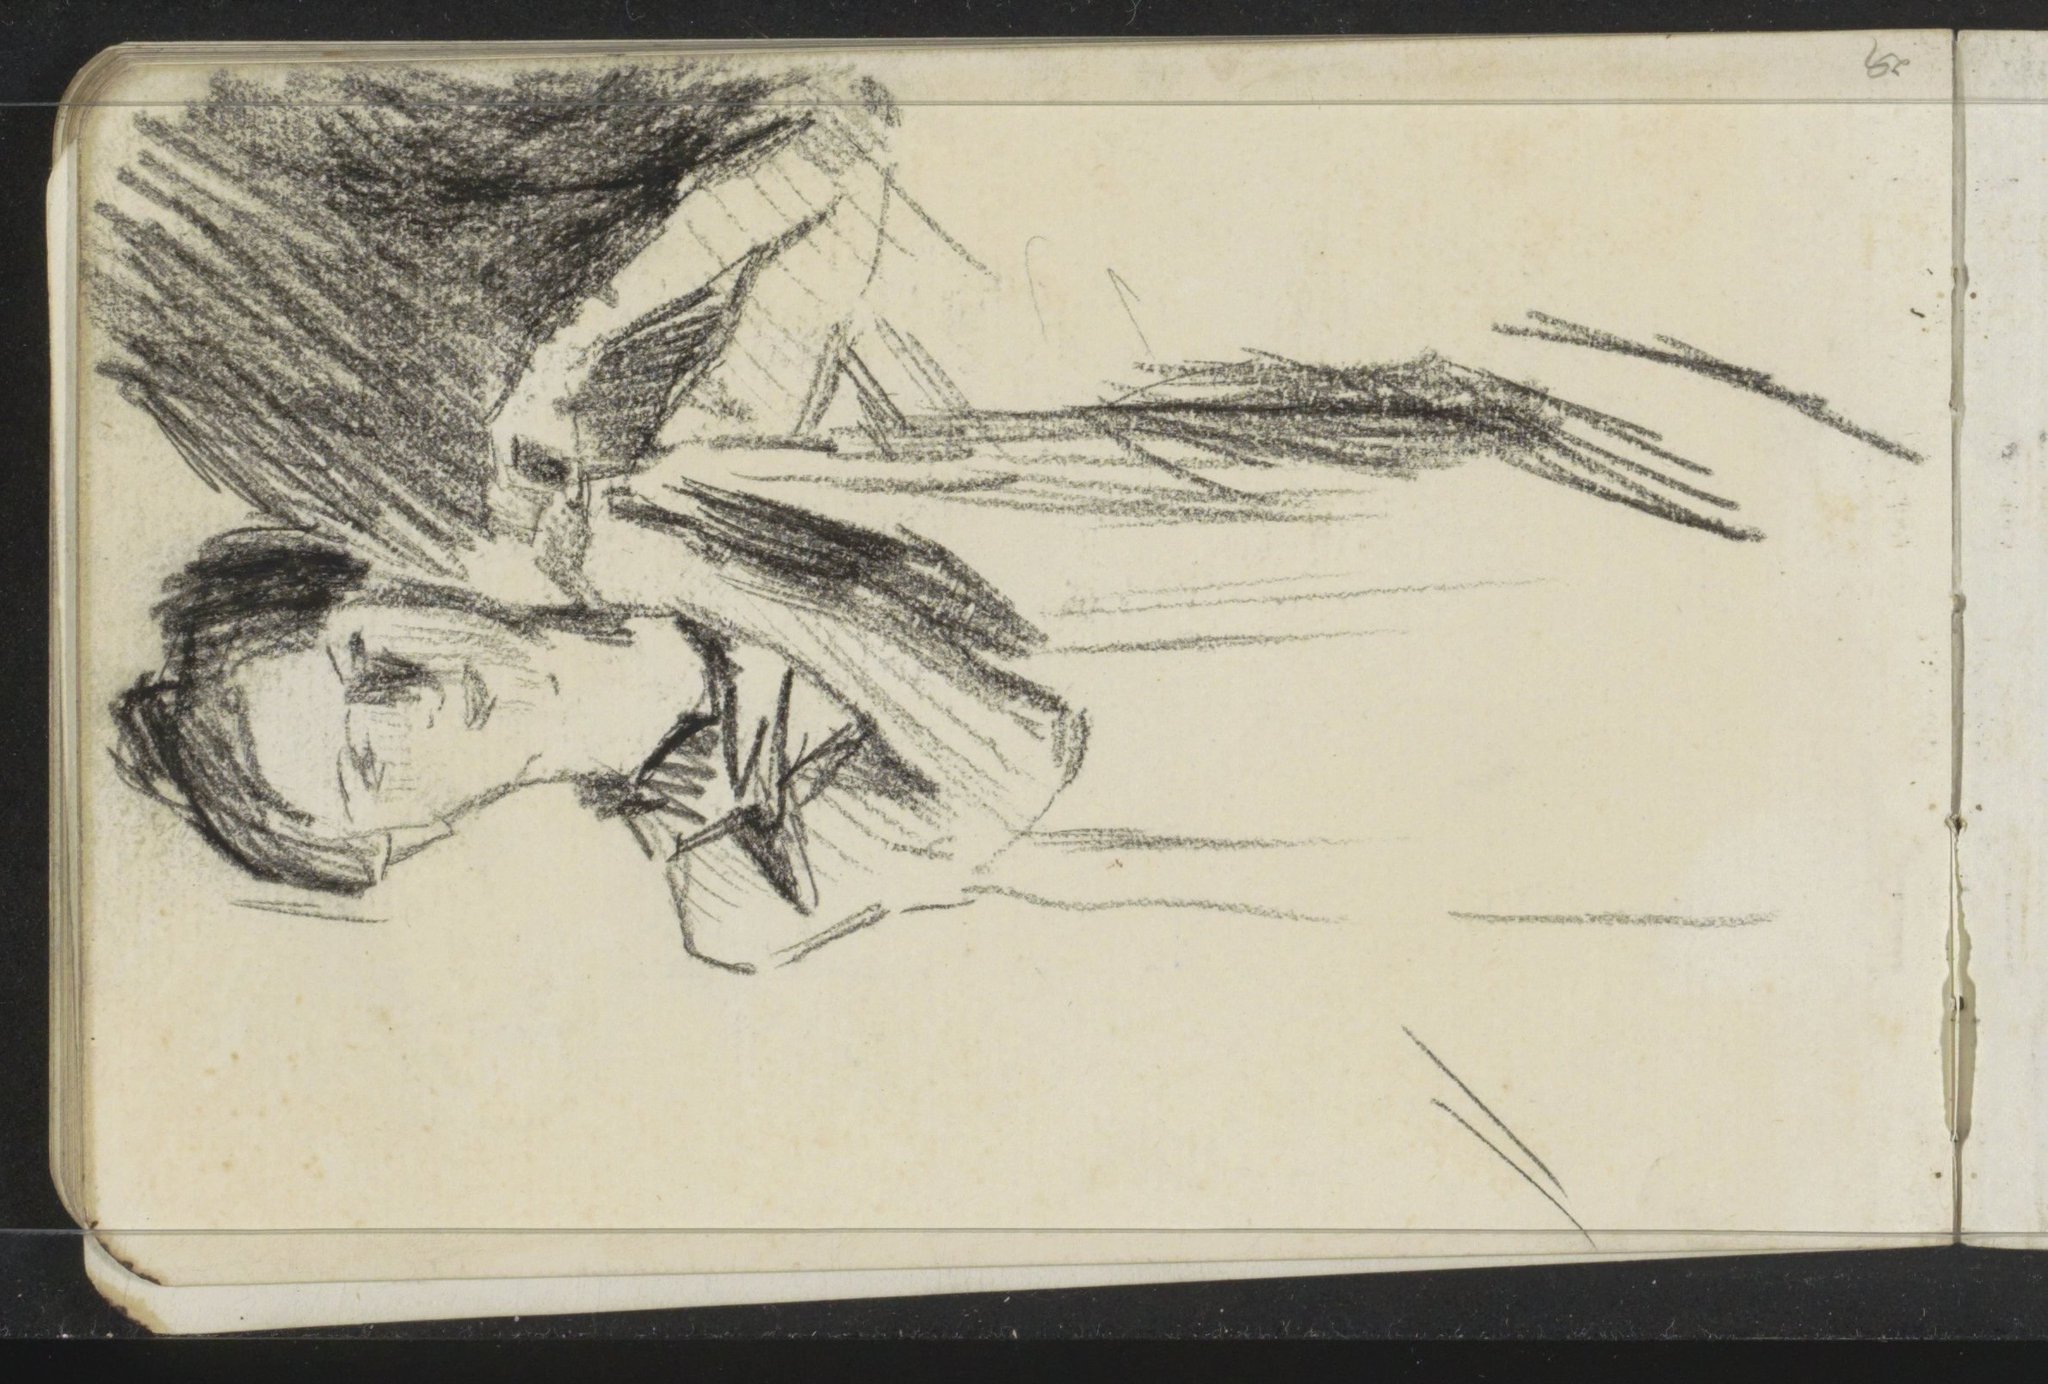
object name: sketchbook leaf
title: Staande vrouw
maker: isaac israels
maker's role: draughtsman, painter, print maker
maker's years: 1865-1934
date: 1875-1934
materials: chalk, paper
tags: adult woman (+ standing)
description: Ze bevestigt mogelijk iets op haar schouder. Blad 28 verso uit schetsboek LXII met 28 bladen.